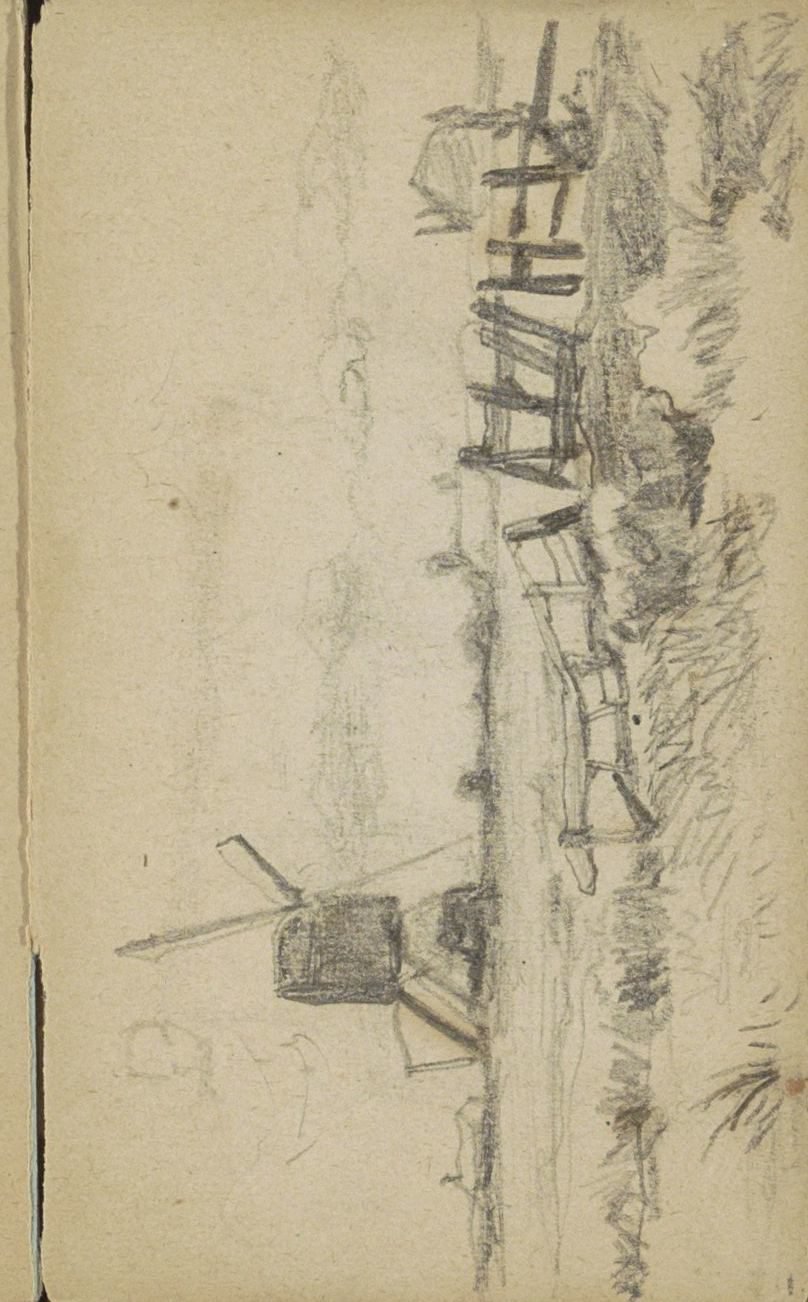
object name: sketchbook leaf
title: Molen in een polderlandschap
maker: johan hendrik weissenbruch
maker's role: draughtsman, painter, print maker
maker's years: 1824-1903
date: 1834-1903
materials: paper, pencil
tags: windmill in landscape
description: Op de voorgrond een hek bij een sloot. Blad 1 recto uit een schetsboek met 32 bladen.